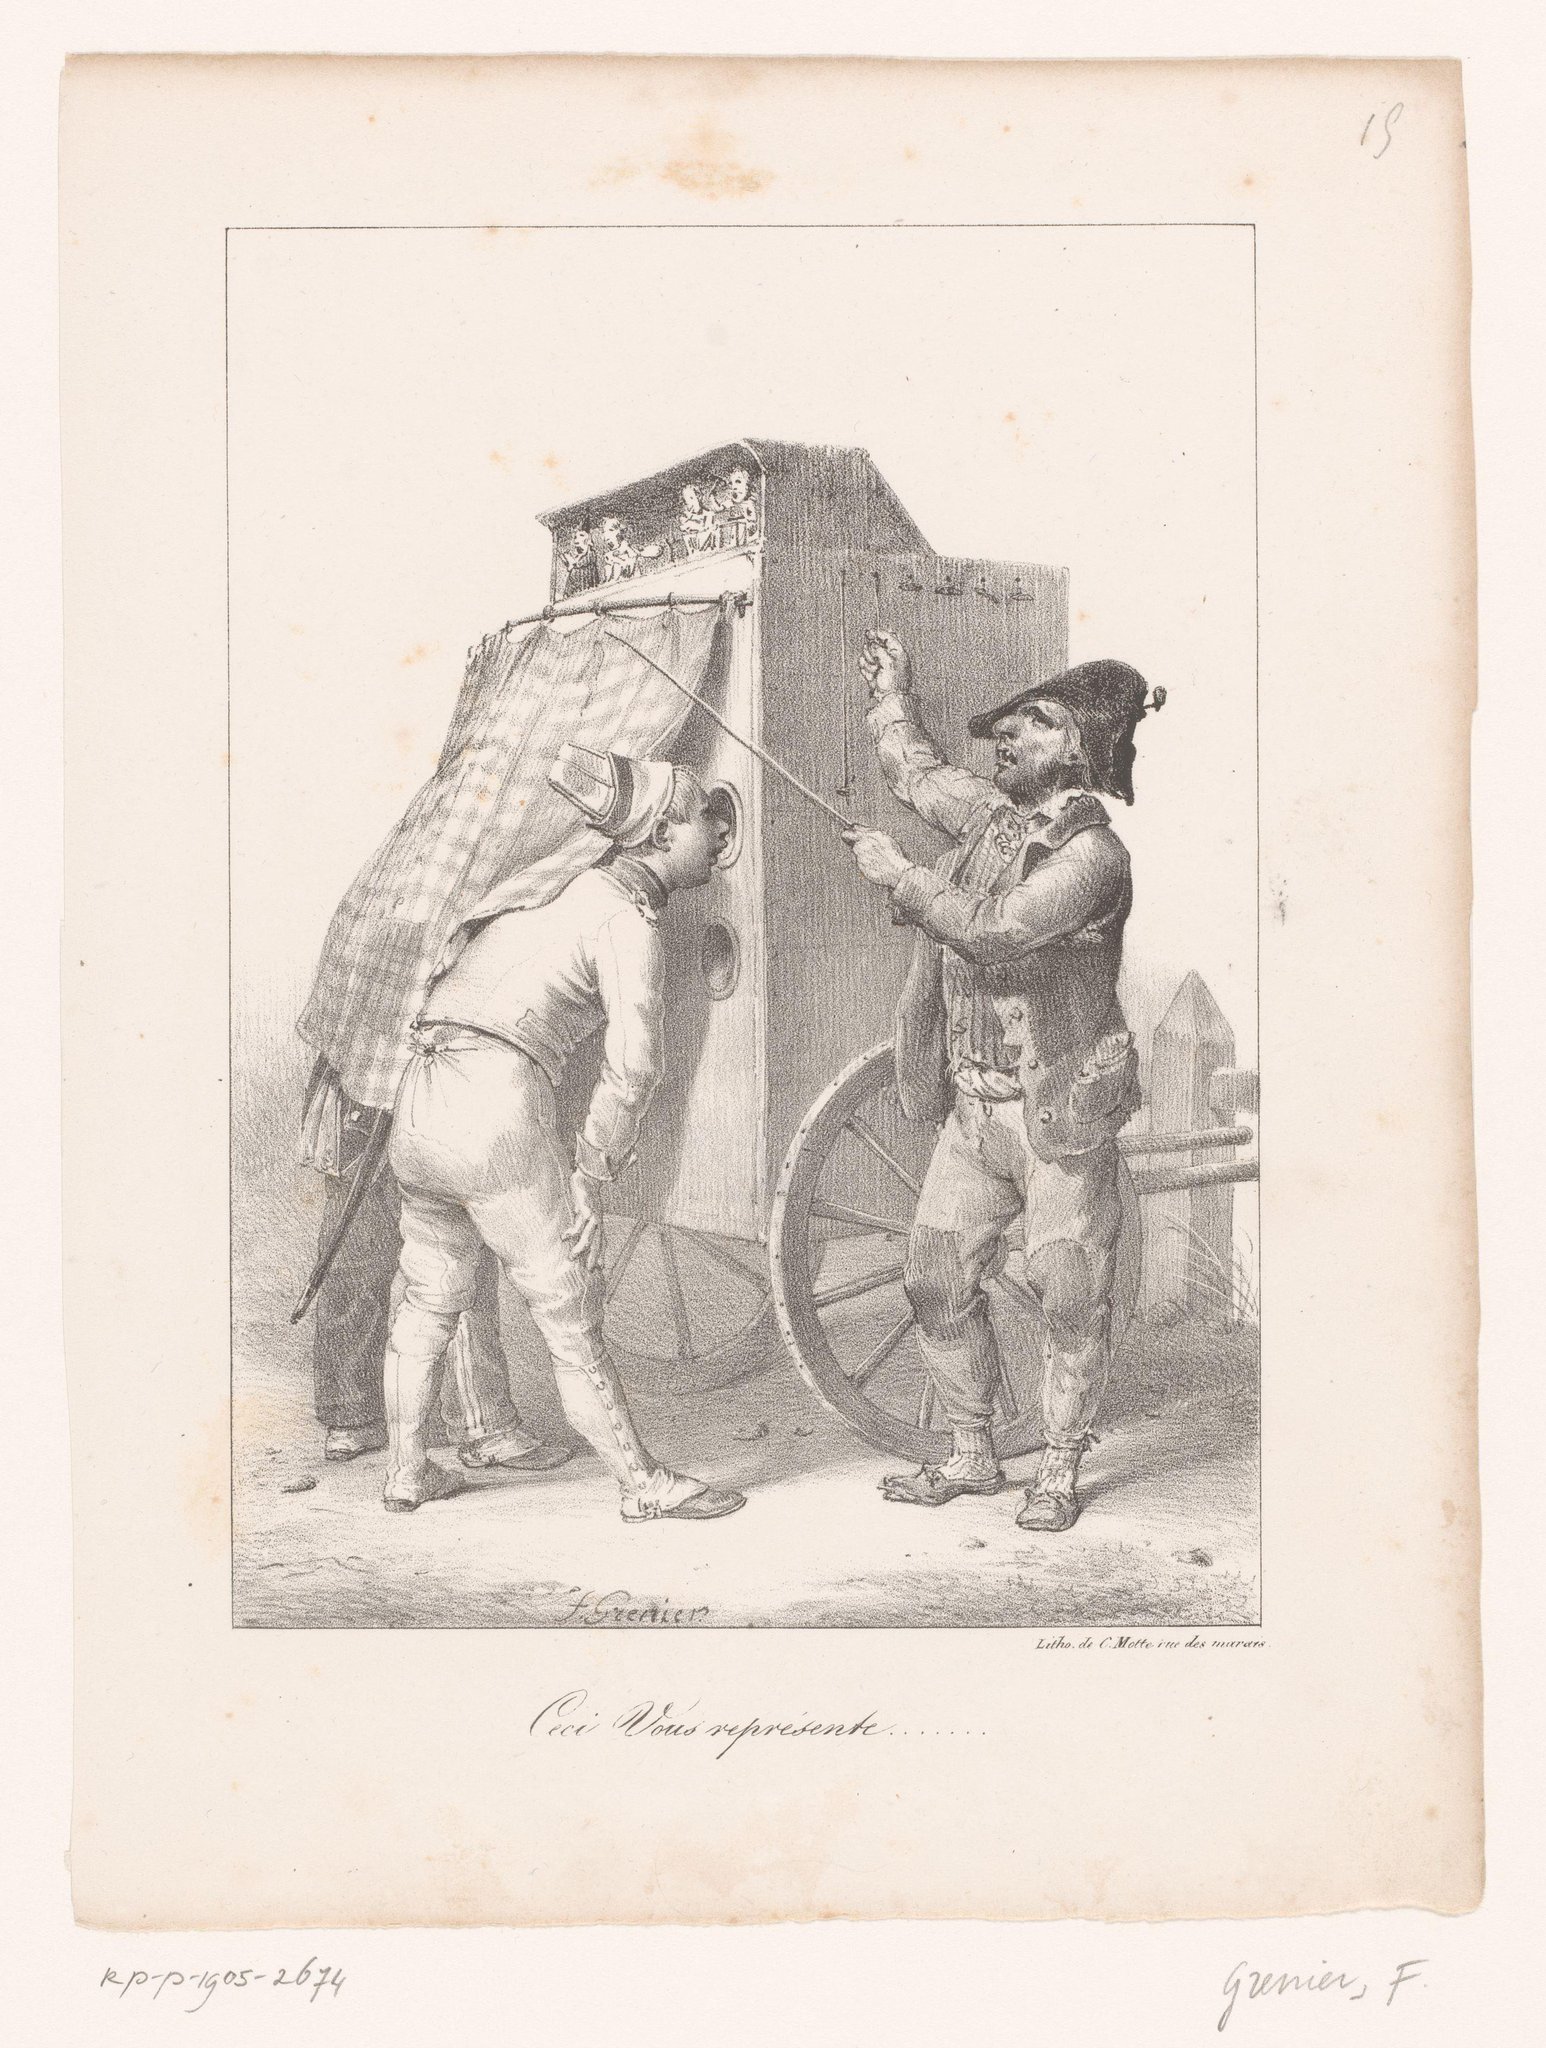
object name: print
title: Marionettenspeler laat publiek in poppenkast kijken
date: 1819-1836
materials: paper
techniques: lithograph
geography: paris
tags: view through a window from the outside, puppet and marionette show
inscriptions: collector's mark: Lugt 2228a